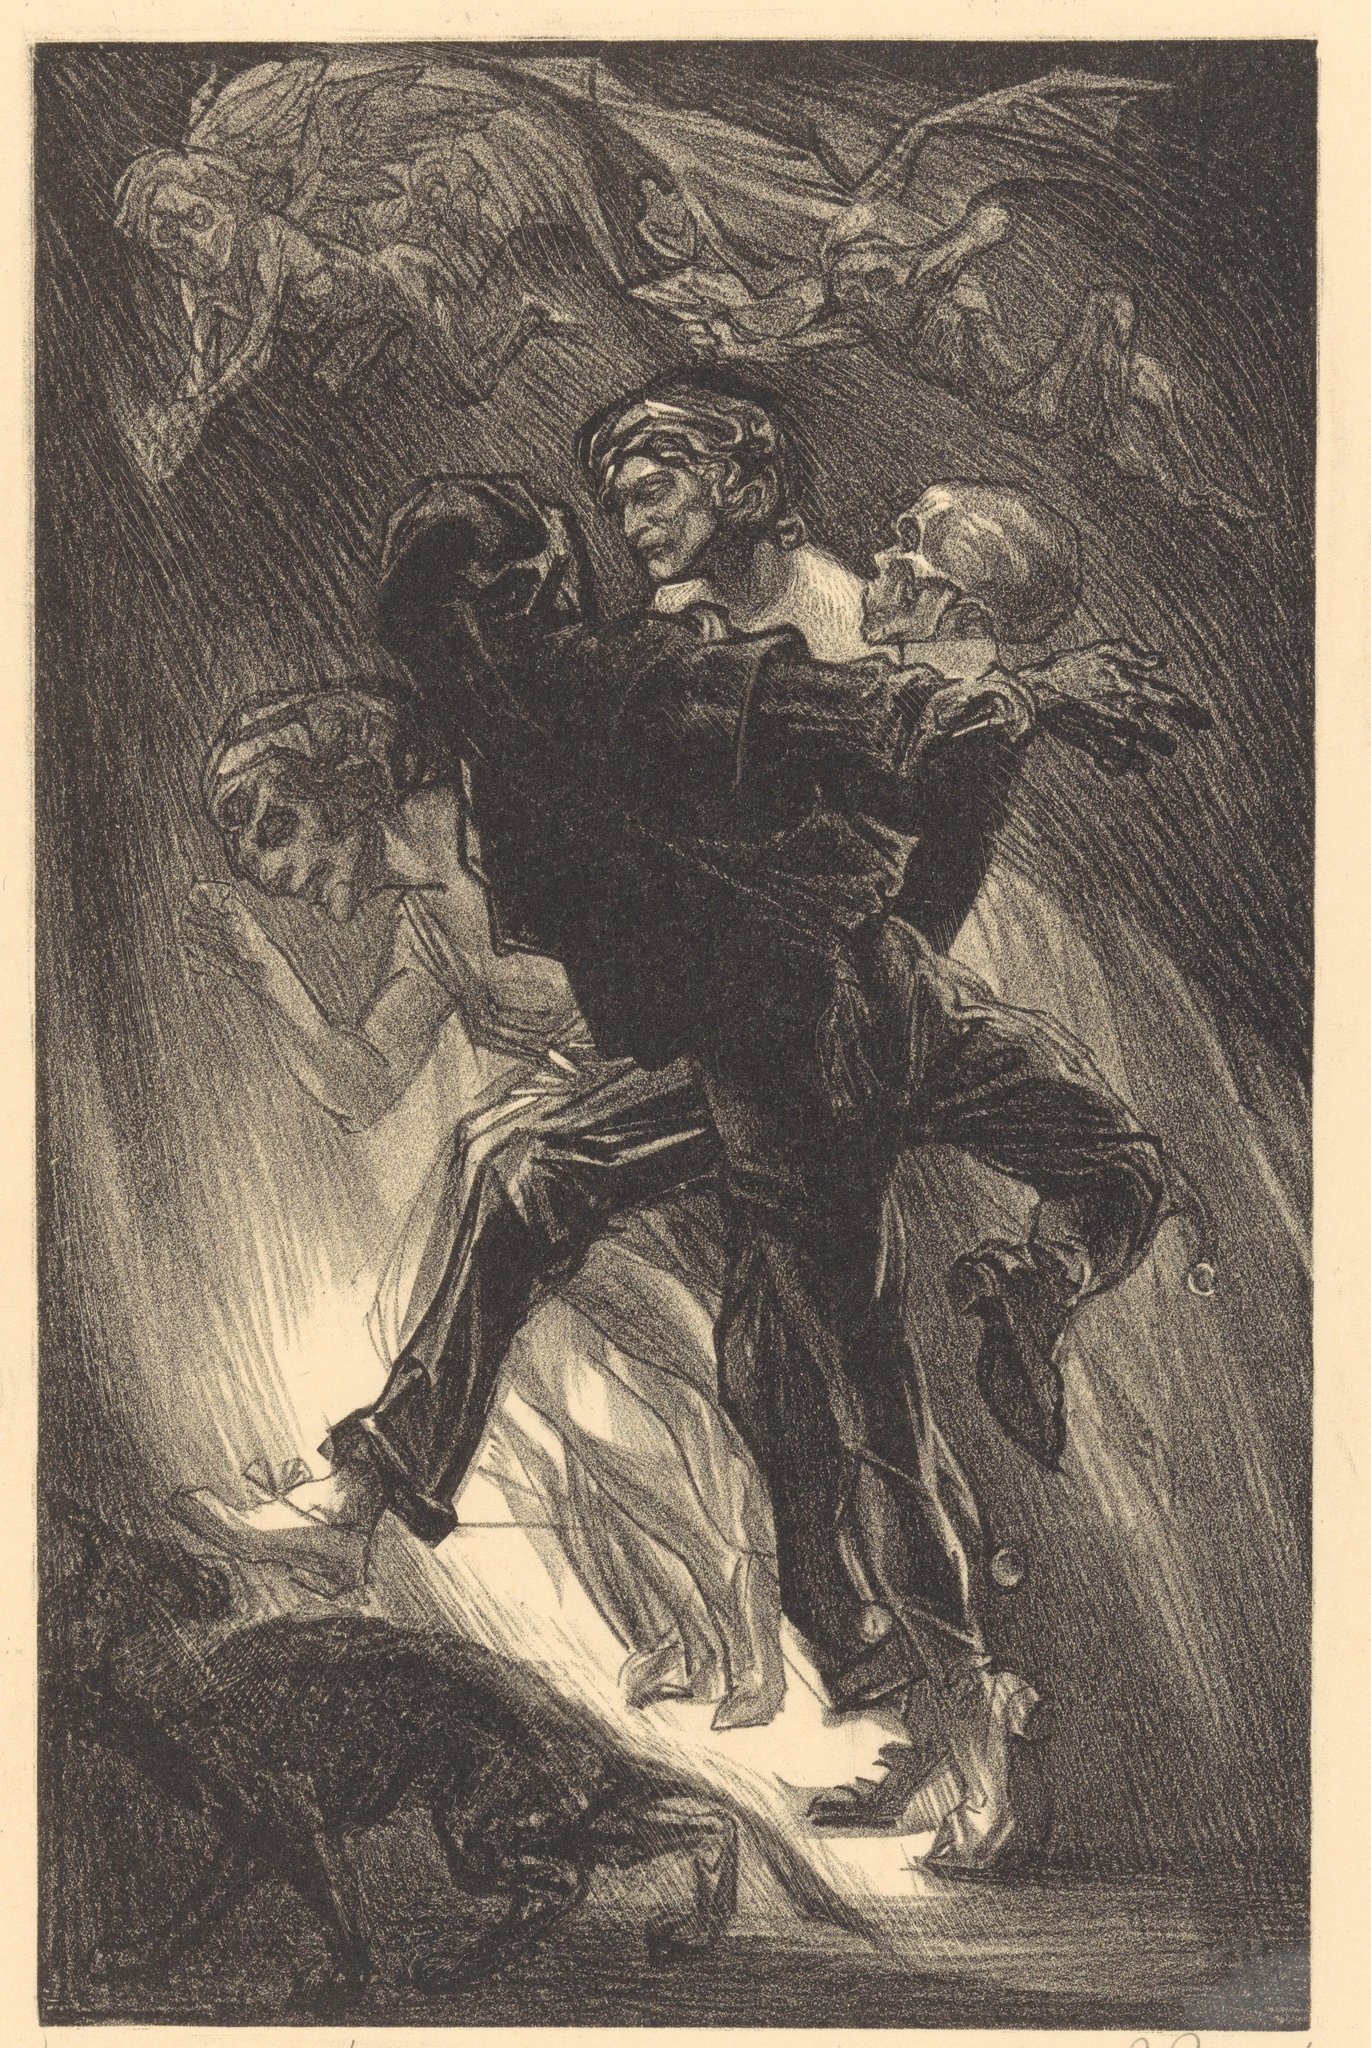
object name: print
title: Dodendans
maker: johannes josephus aarts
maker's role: draughtsman, print maker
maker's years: 1871-1934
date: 1927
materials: paper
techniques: lithograph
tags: court jester, court fool, devil(s) and demons, dance of death; death together with one or more human beings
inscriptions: collector's mark: Lugt 2760, collector's mark: Lugt 2228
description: Een groep van vier dansende figuren, waaronder een skelet in een pak en een nar. Boven hen twee gevleugelde duivels, waarvan één de armen zo houdt alsof hij met pijl en boog schiet. Links op de voorgrond een hond.